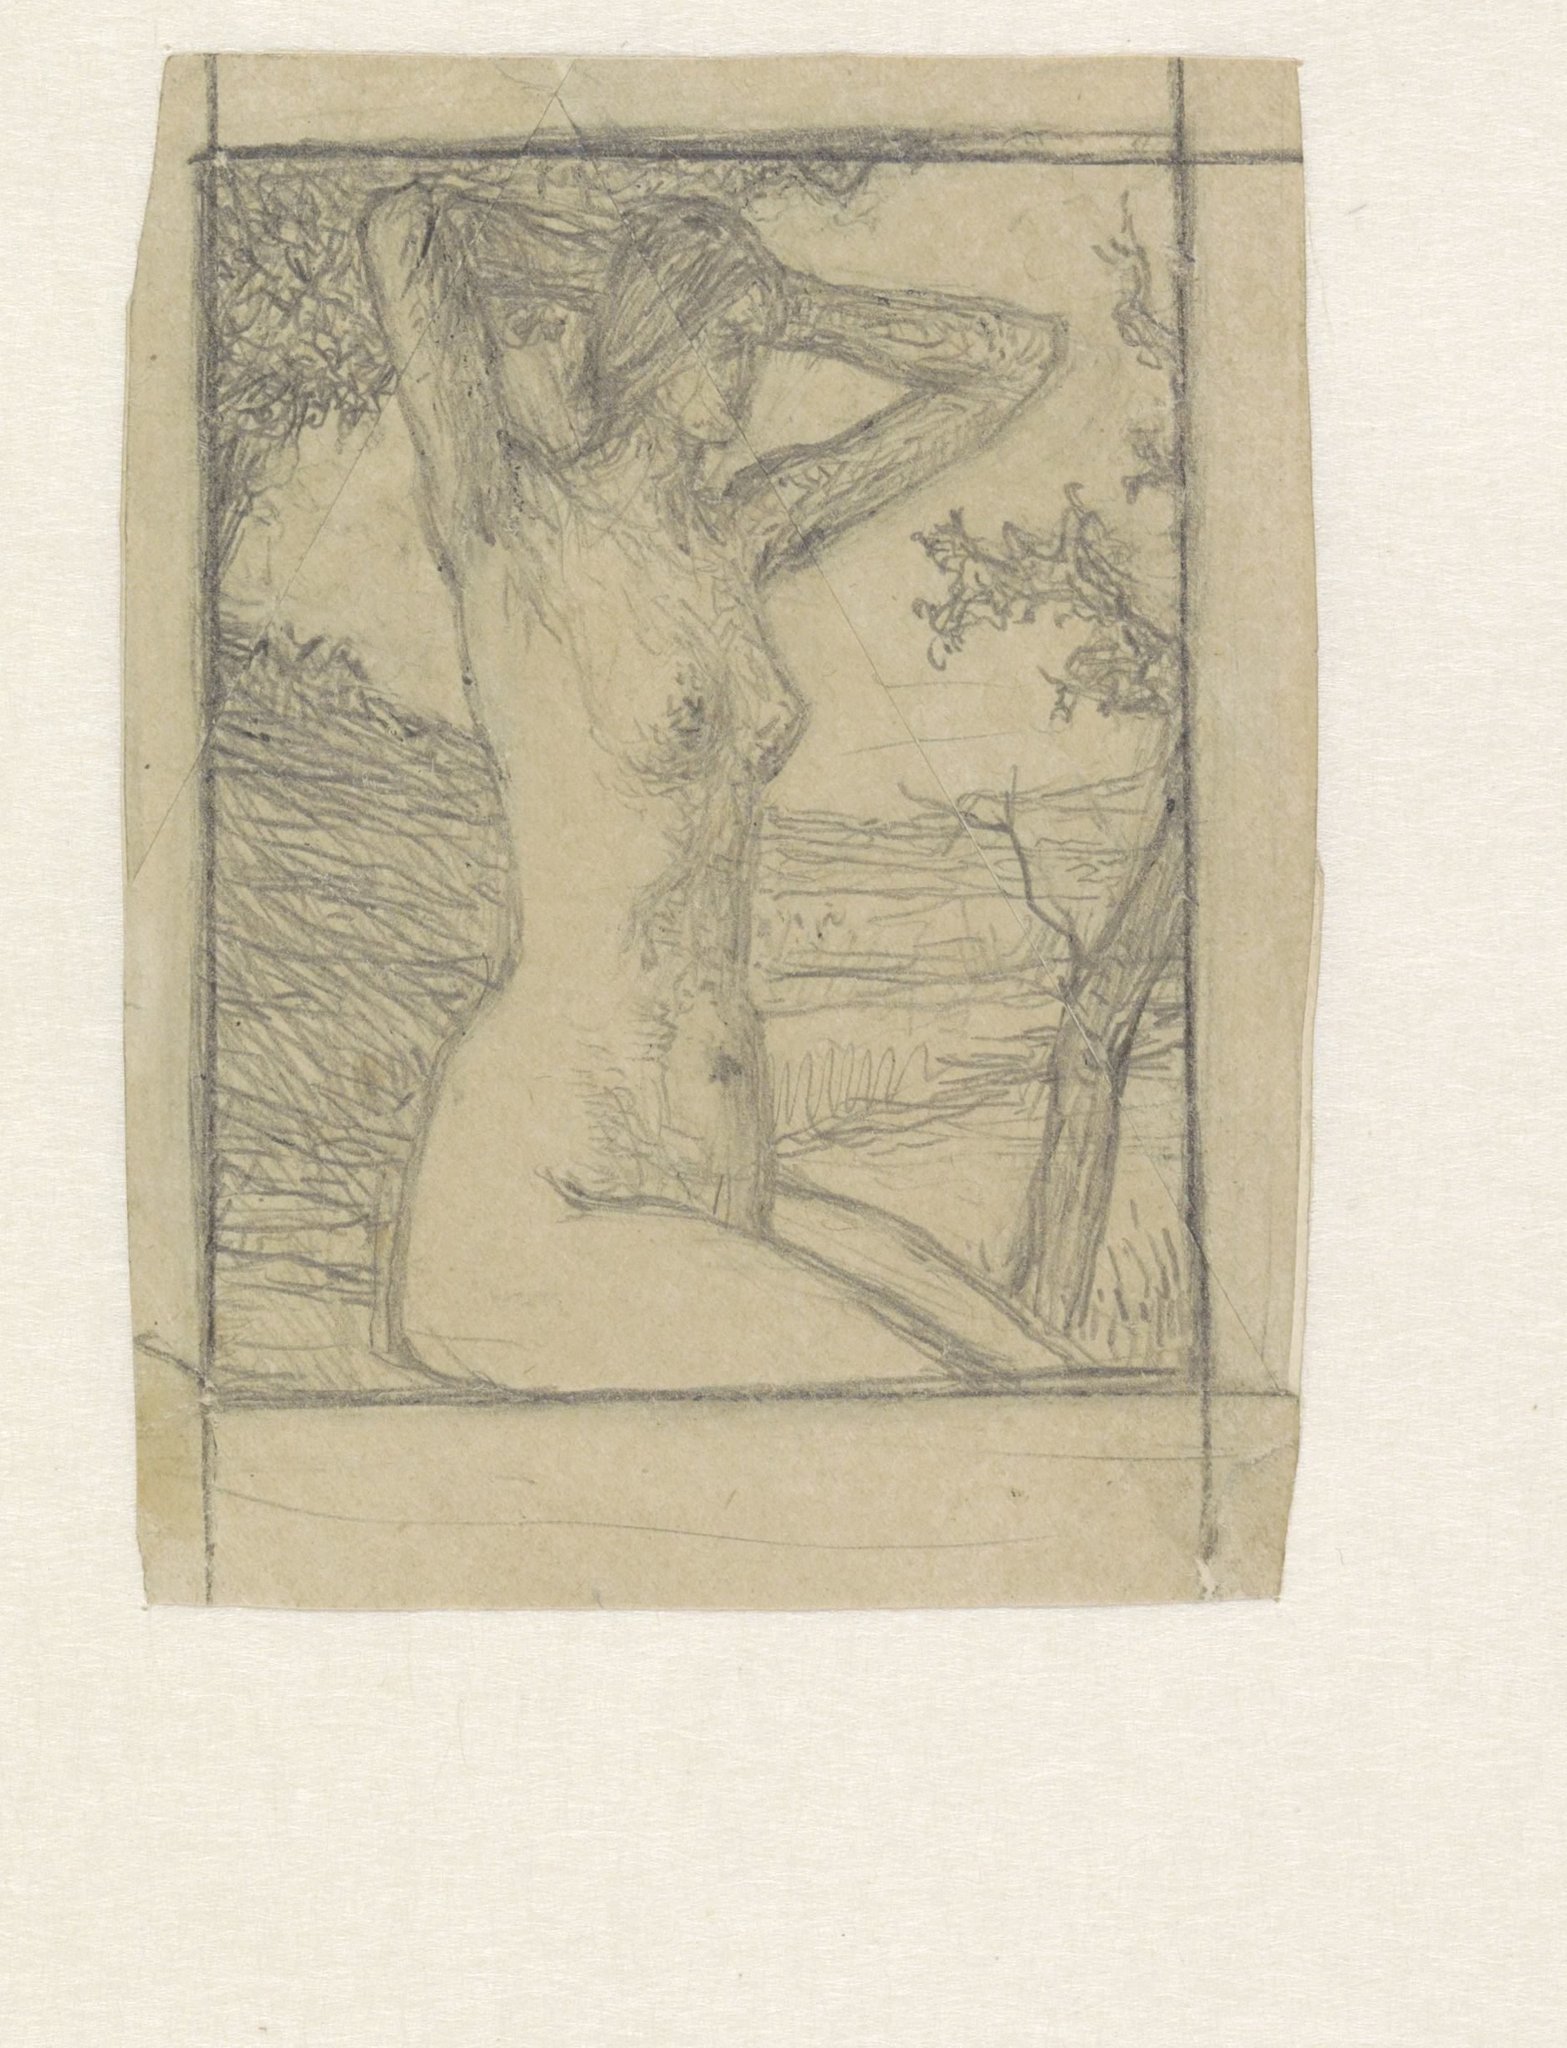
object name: drawing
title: Zittend vrouwelijk naakt in landschap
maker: jan veth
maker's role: designer, draughtsman, painter, print maker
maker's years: 1864-1925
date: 1874-1925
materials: paper, pencil